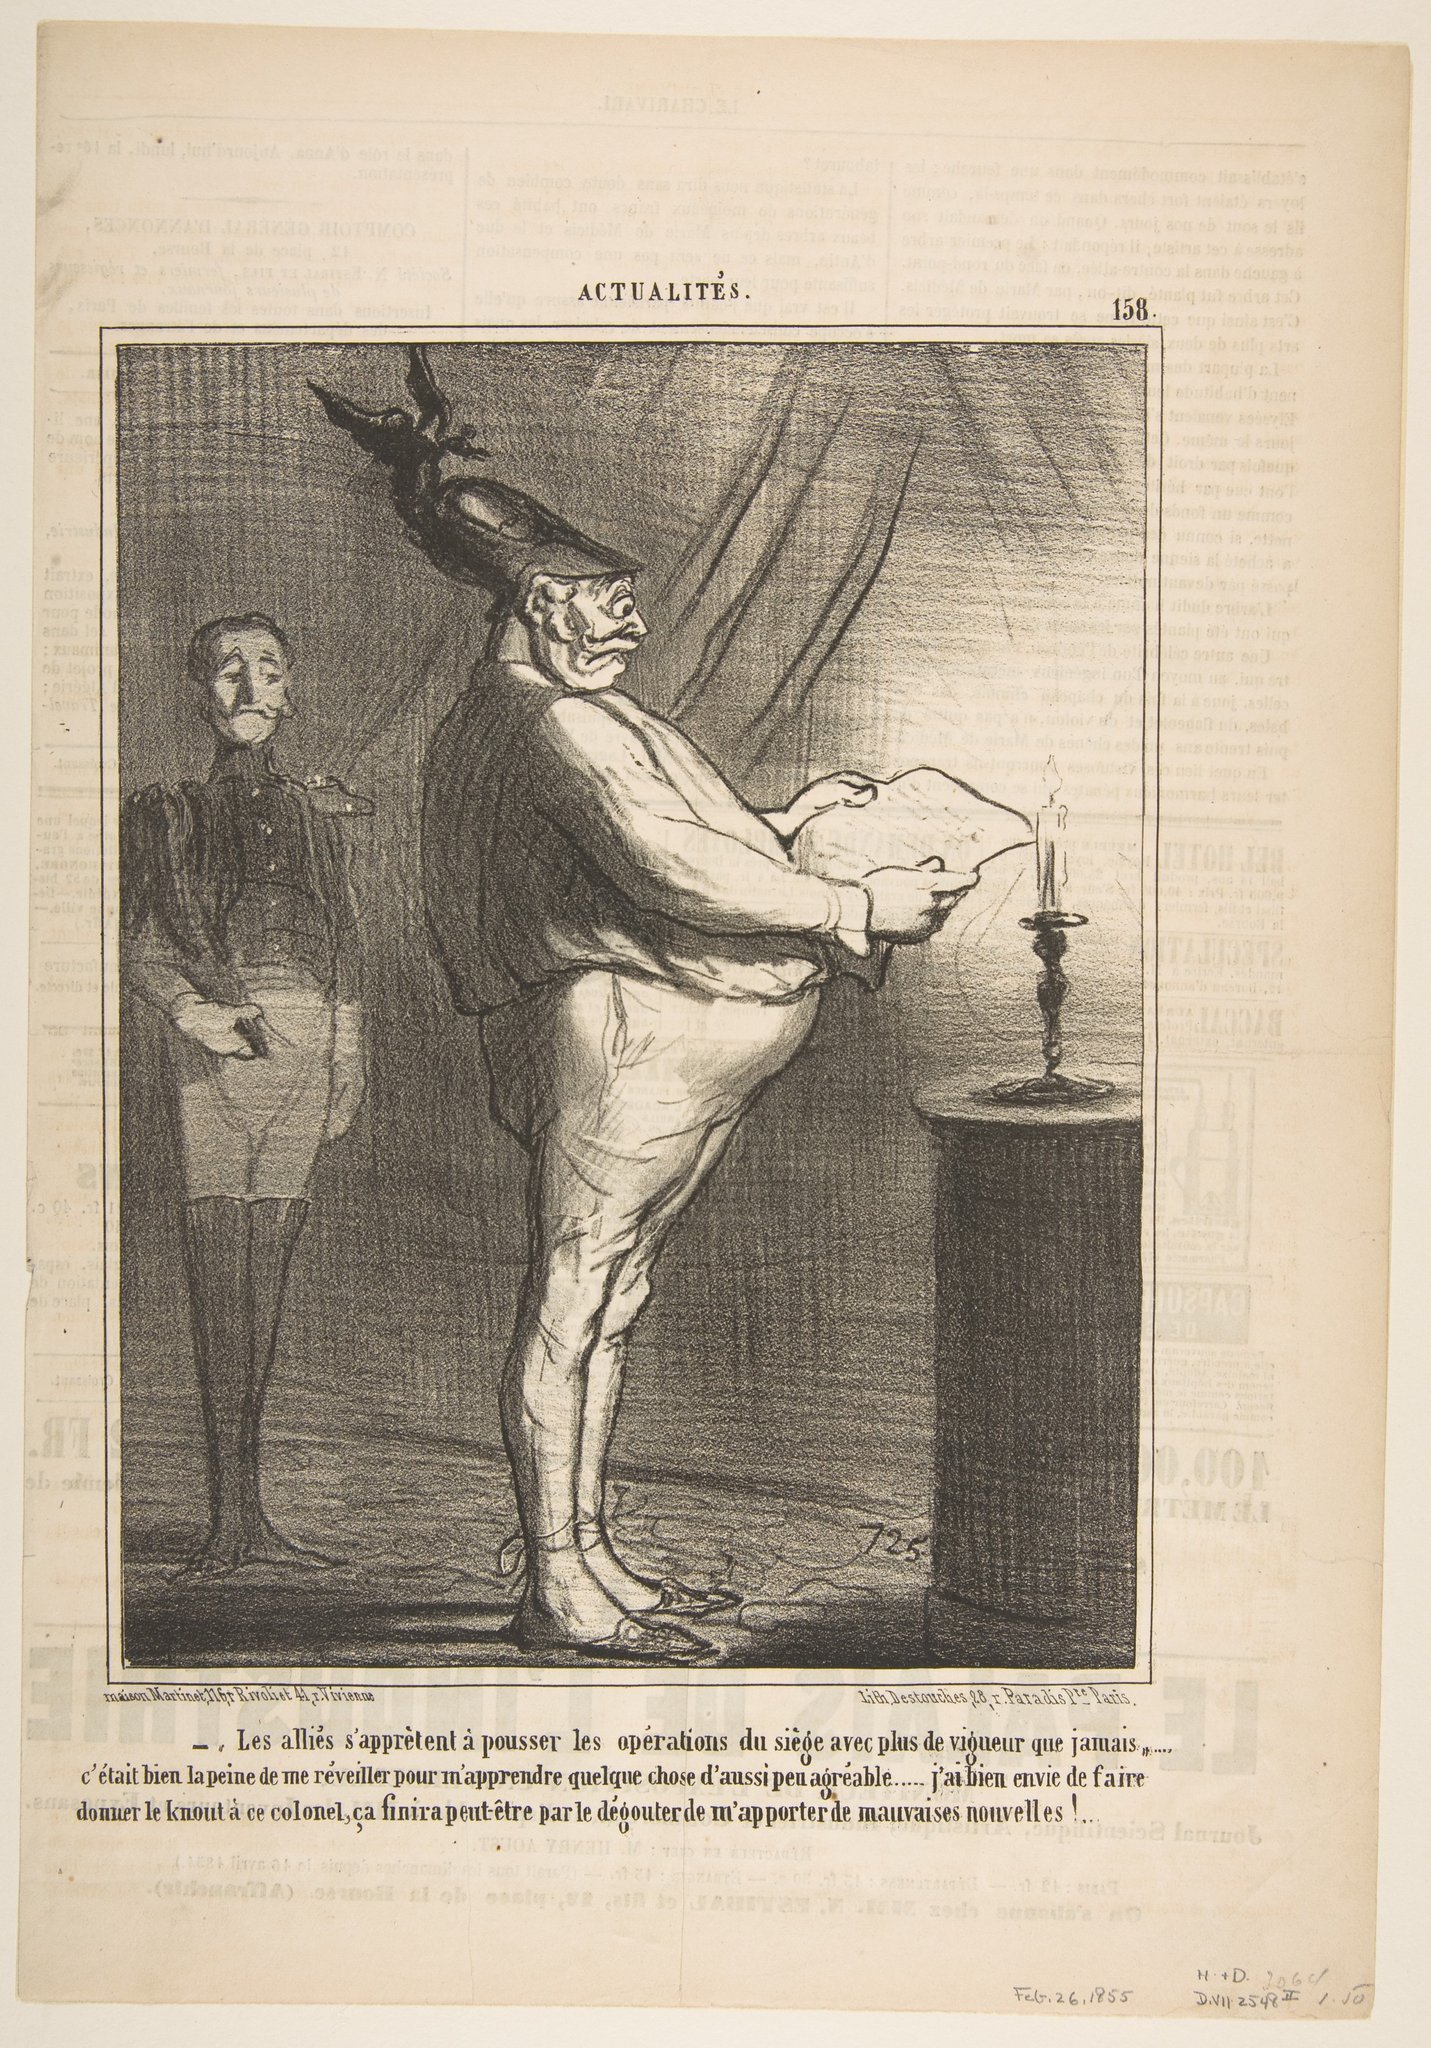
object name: print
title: Les allies s'apprètent à pousser les opérations du siège avec plus de vigueur que jamais…, from "Actualités"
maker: honoré daumier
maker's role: artist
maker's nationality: french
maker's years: 1808-1879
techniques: lithograph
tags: satire,men